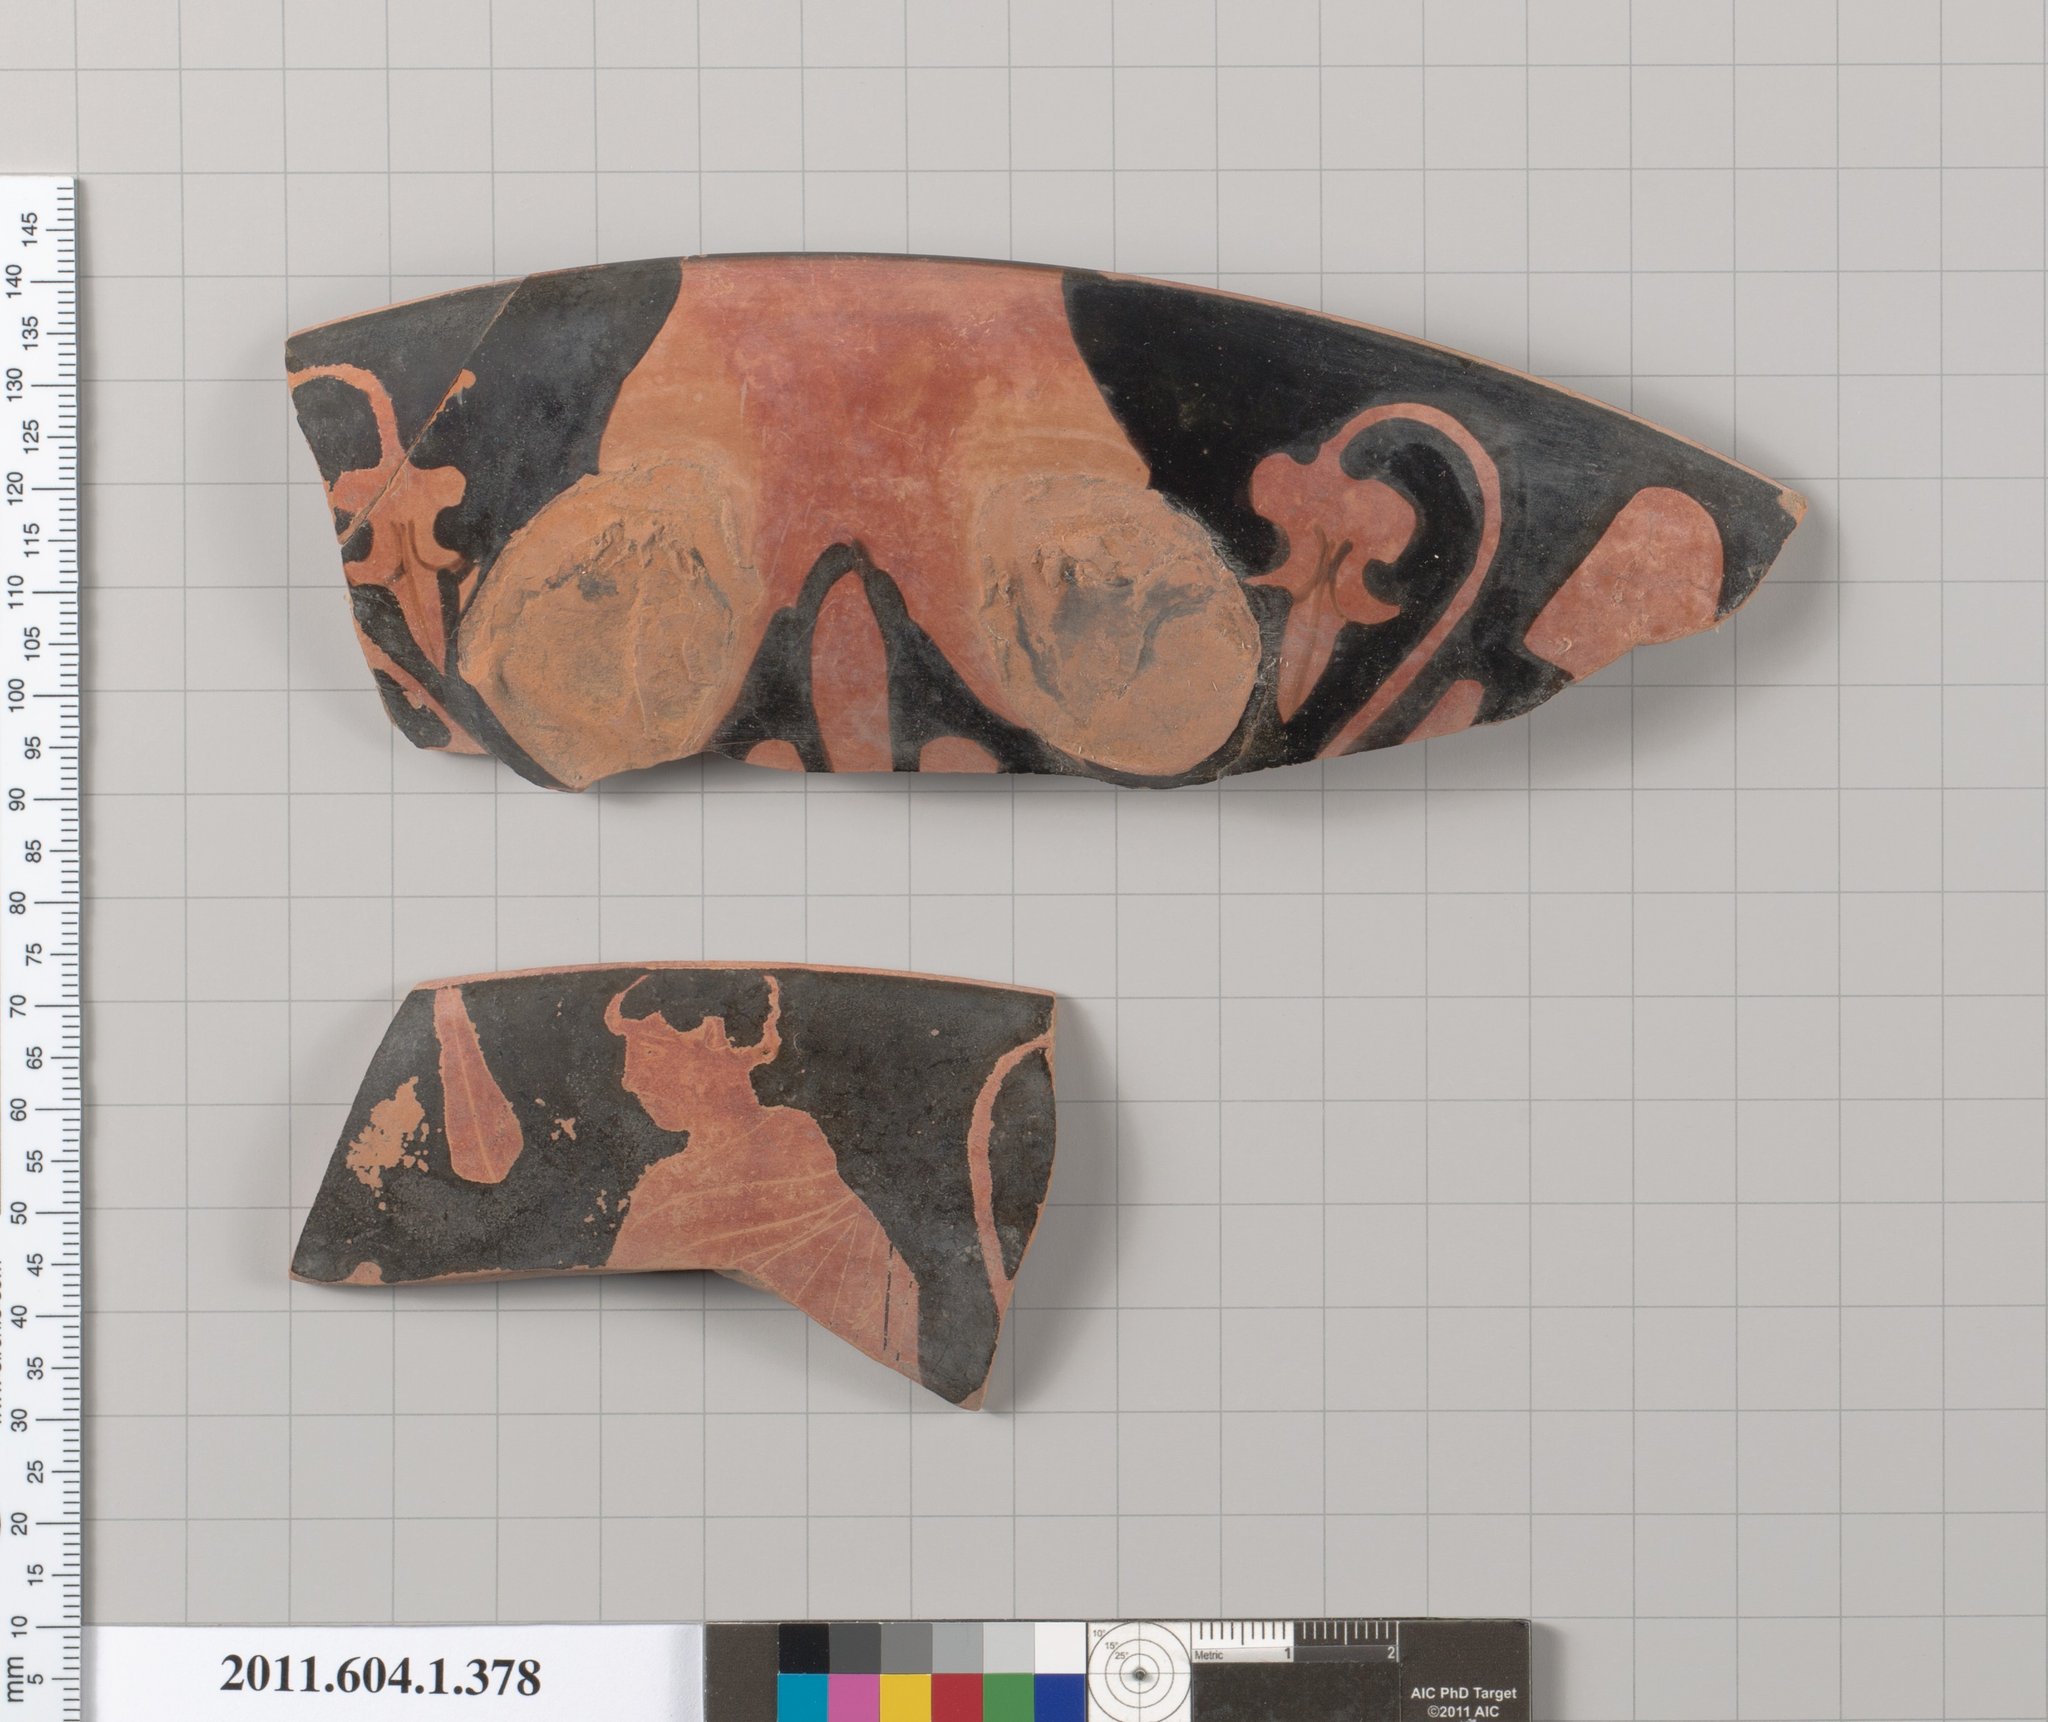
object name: kylix fragment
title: Terracotta fragment of a kylix (drinking cup)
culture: greek, attic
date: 467-435 BCE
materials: terracotta